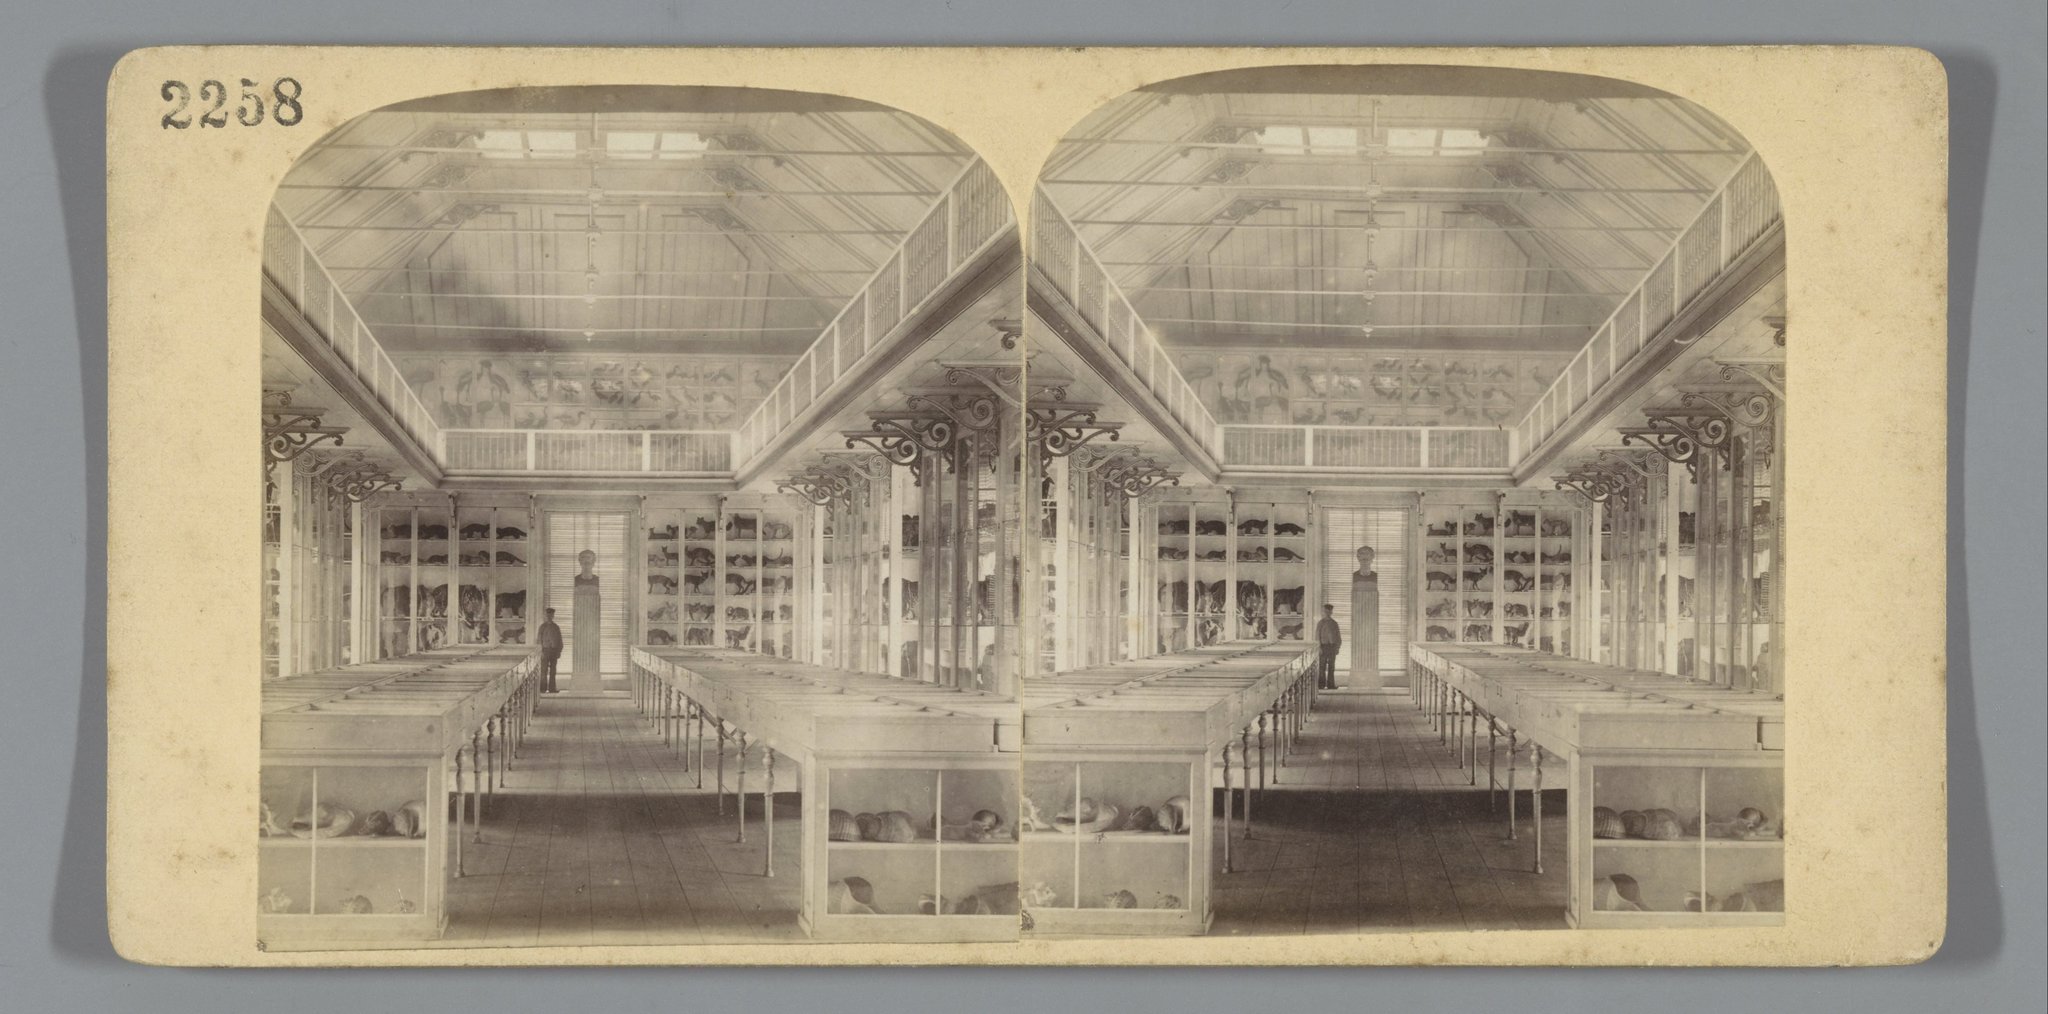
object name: stereograph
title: Expositieruimte in Artis, Amsterdam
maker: Anonymous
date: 1879-1910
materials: cardboard, paper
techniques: albumen print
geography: amsterdam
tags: collection, exhibition, show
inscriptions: number: ‘2258’